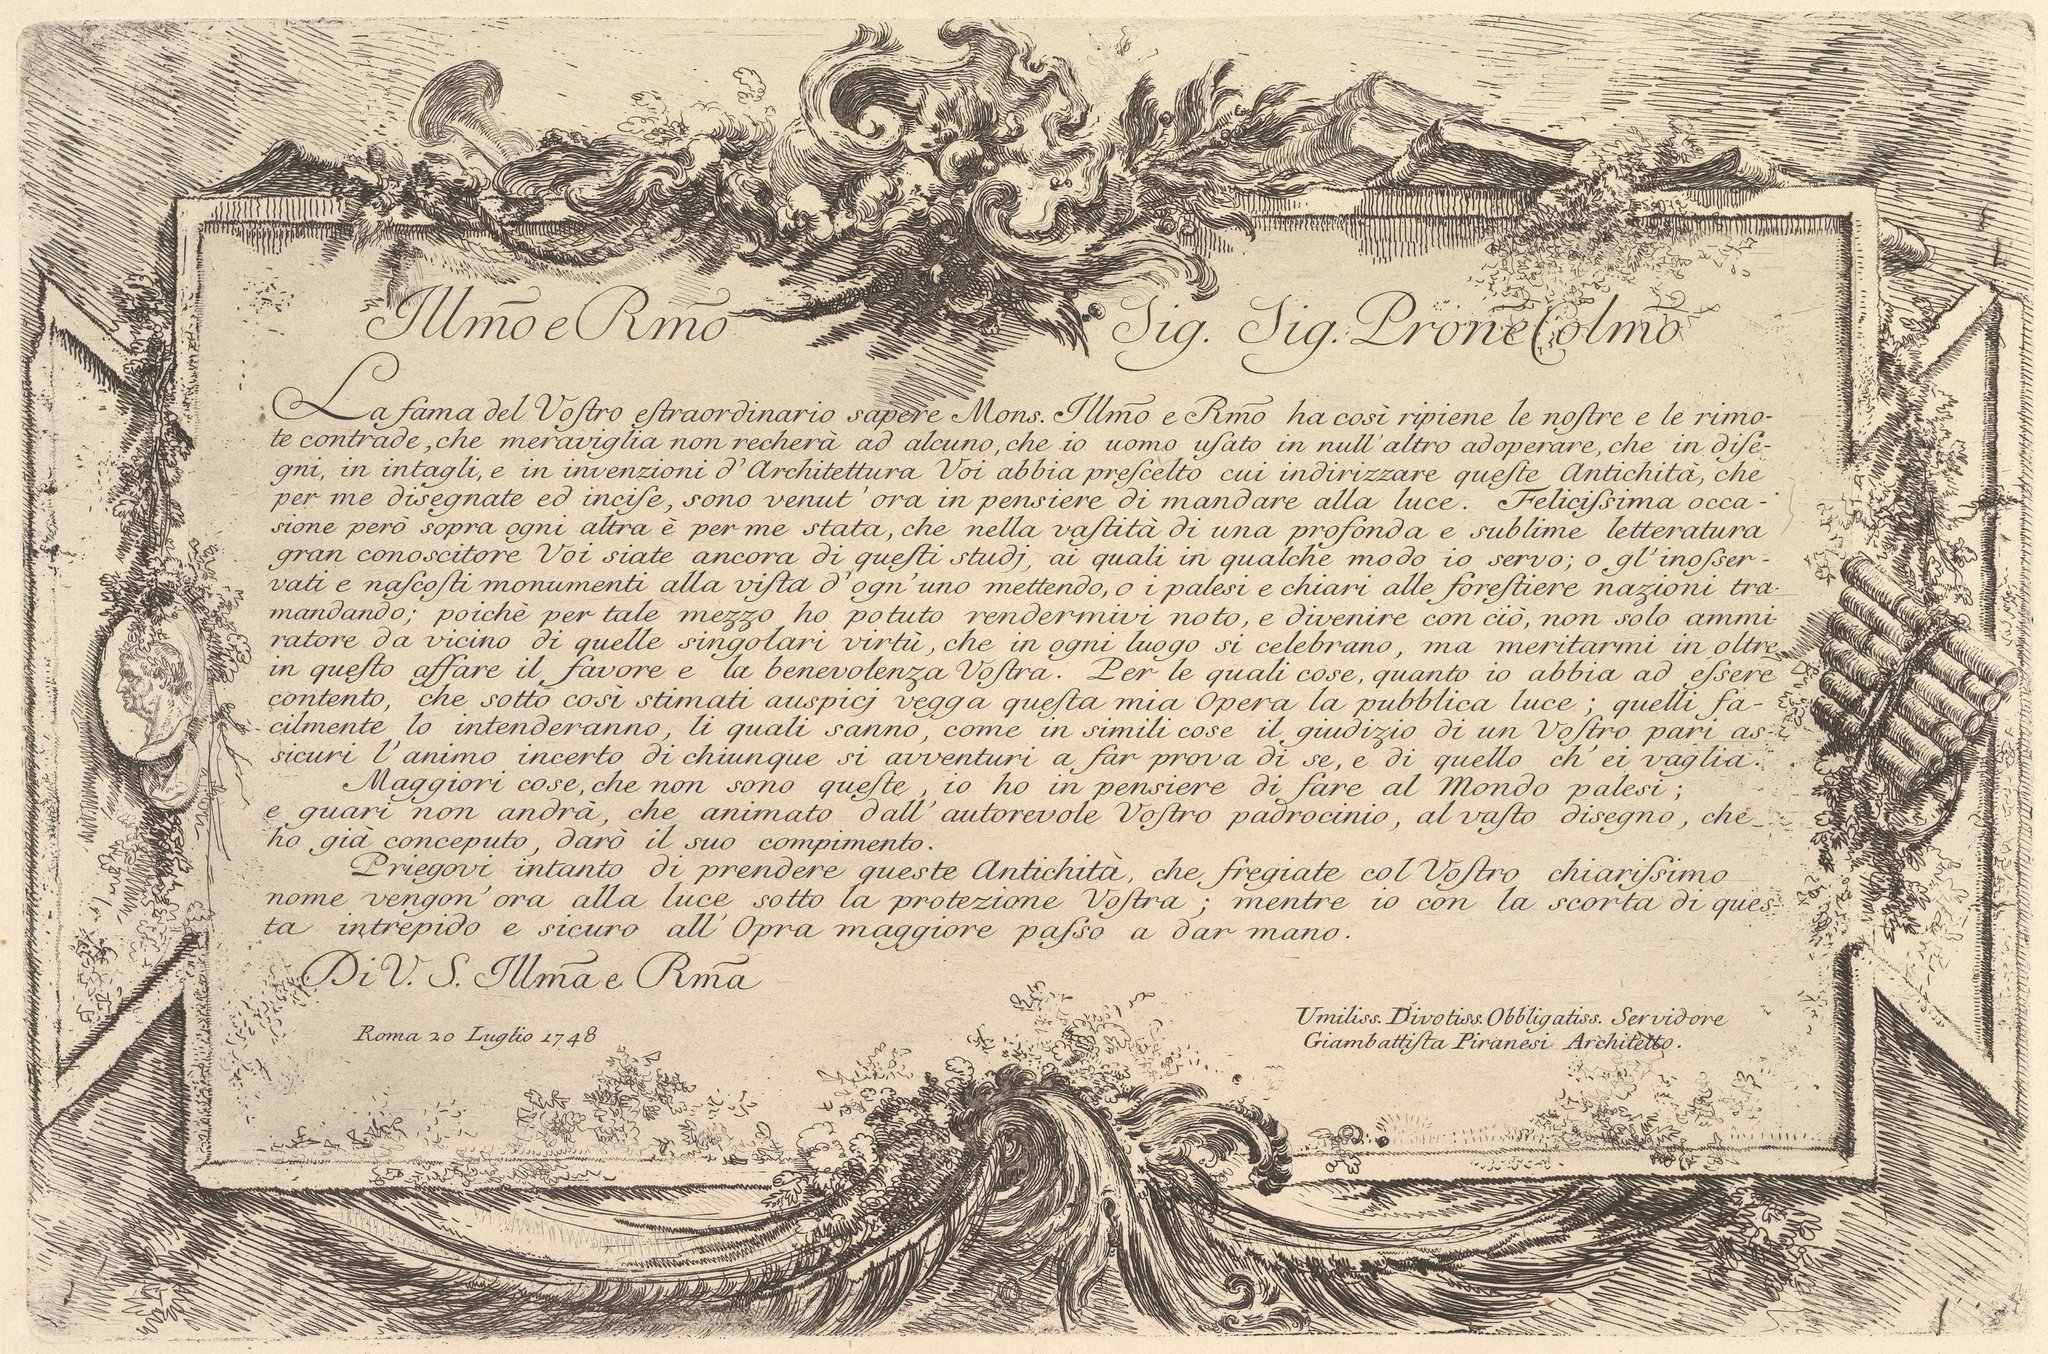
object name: print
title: Dedication to Giovanni Bottari (Dédicace à Bottari), from "Antichità Romane de' Tempi della Repubblica, e de' primi Imperatori"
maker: giovanni battista piranesi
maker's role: artist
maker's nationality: italian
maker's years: 1720-1778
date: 1748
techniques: etching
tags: ornament